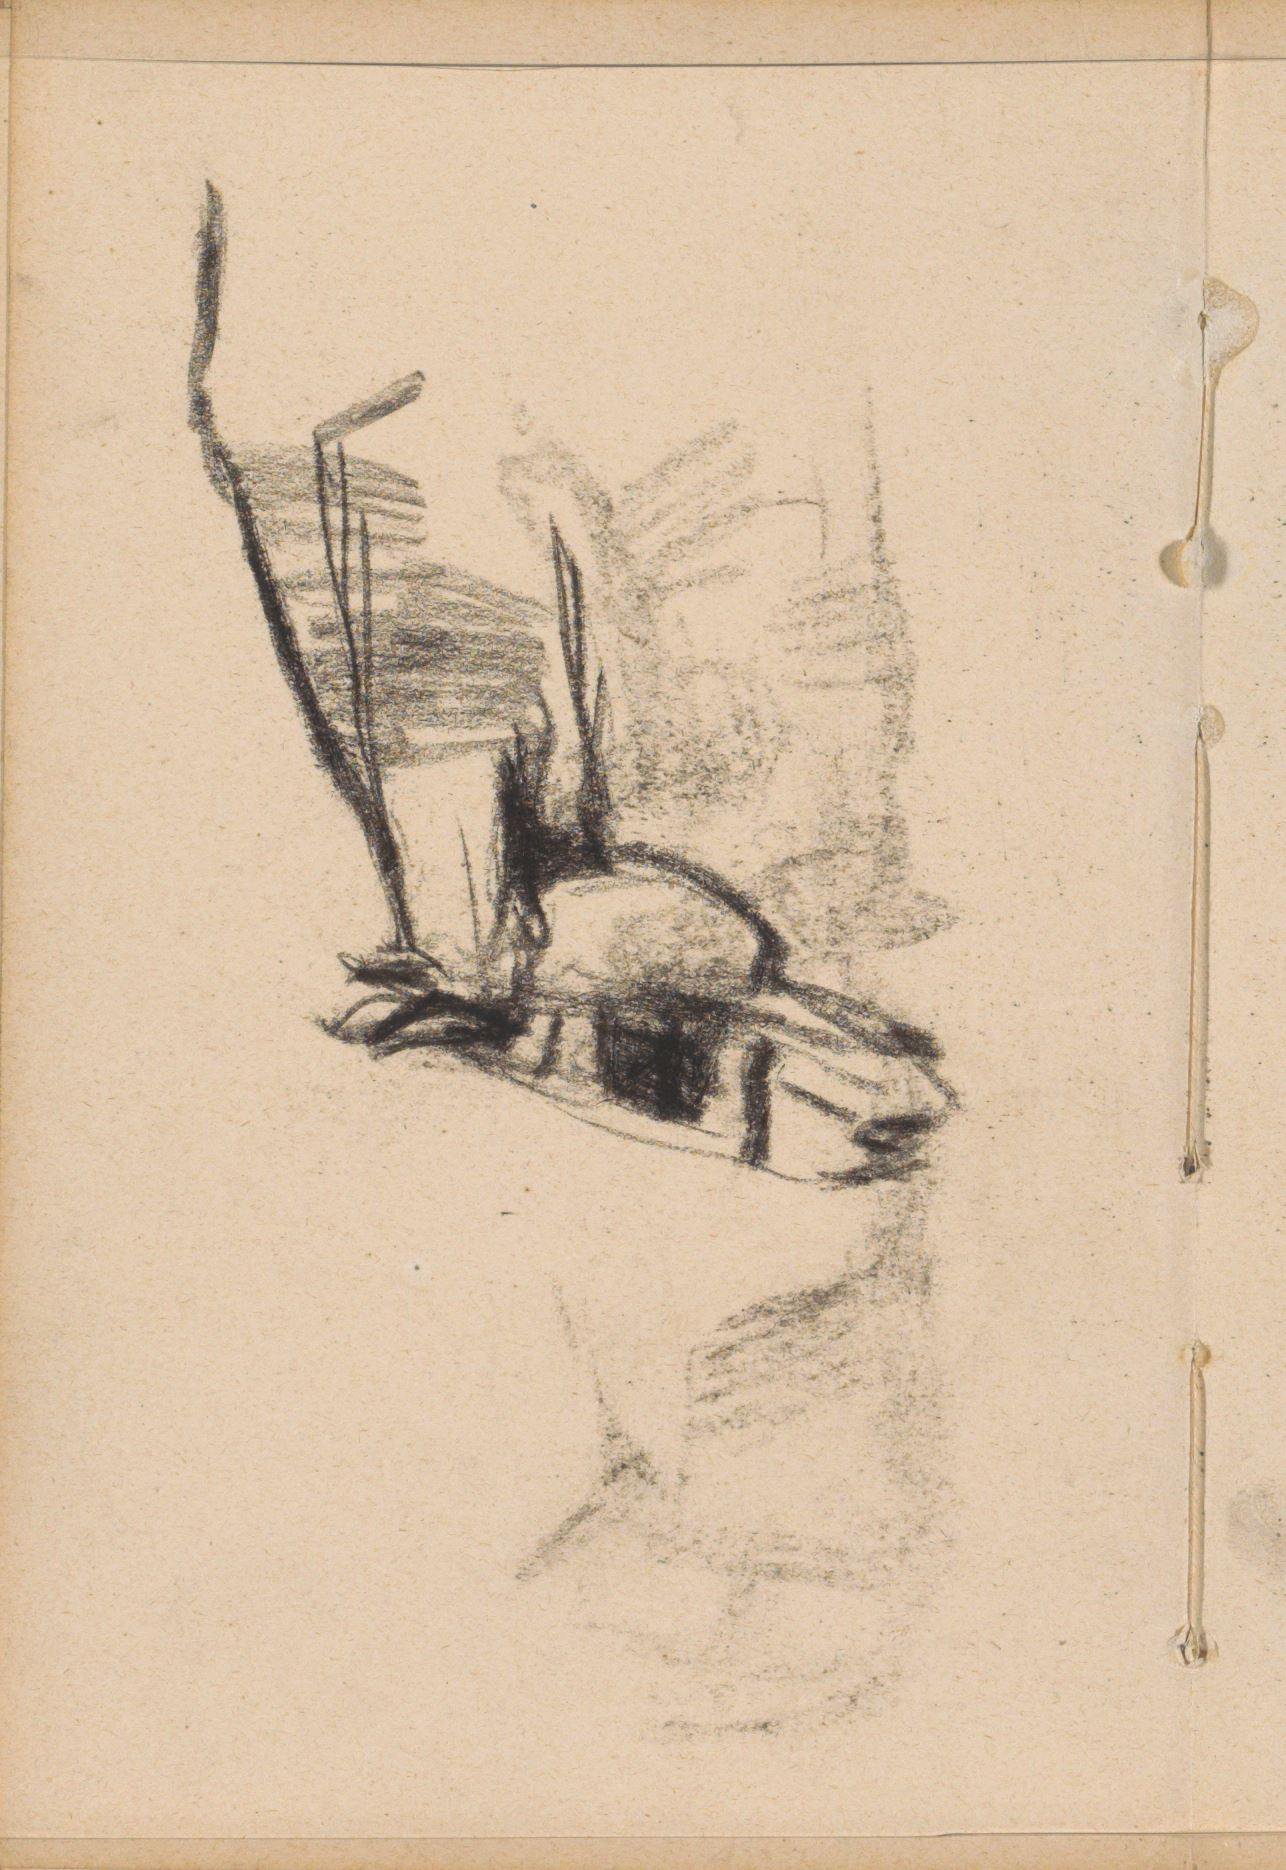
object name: sketchbook leaf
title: Paardenhoofd met oogkleppen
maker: george hendrik breitner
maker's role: draughtsman, painter, print maker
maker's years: 1857-1923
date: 1909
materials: chalk, paper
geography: amsterdam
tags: blinkers, horse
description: Paardenhoofd met oogkleppen. Pagina 35 uit een schetsboek met 45 bladen vervaardigd in Amsterdam en Pittsburgh.